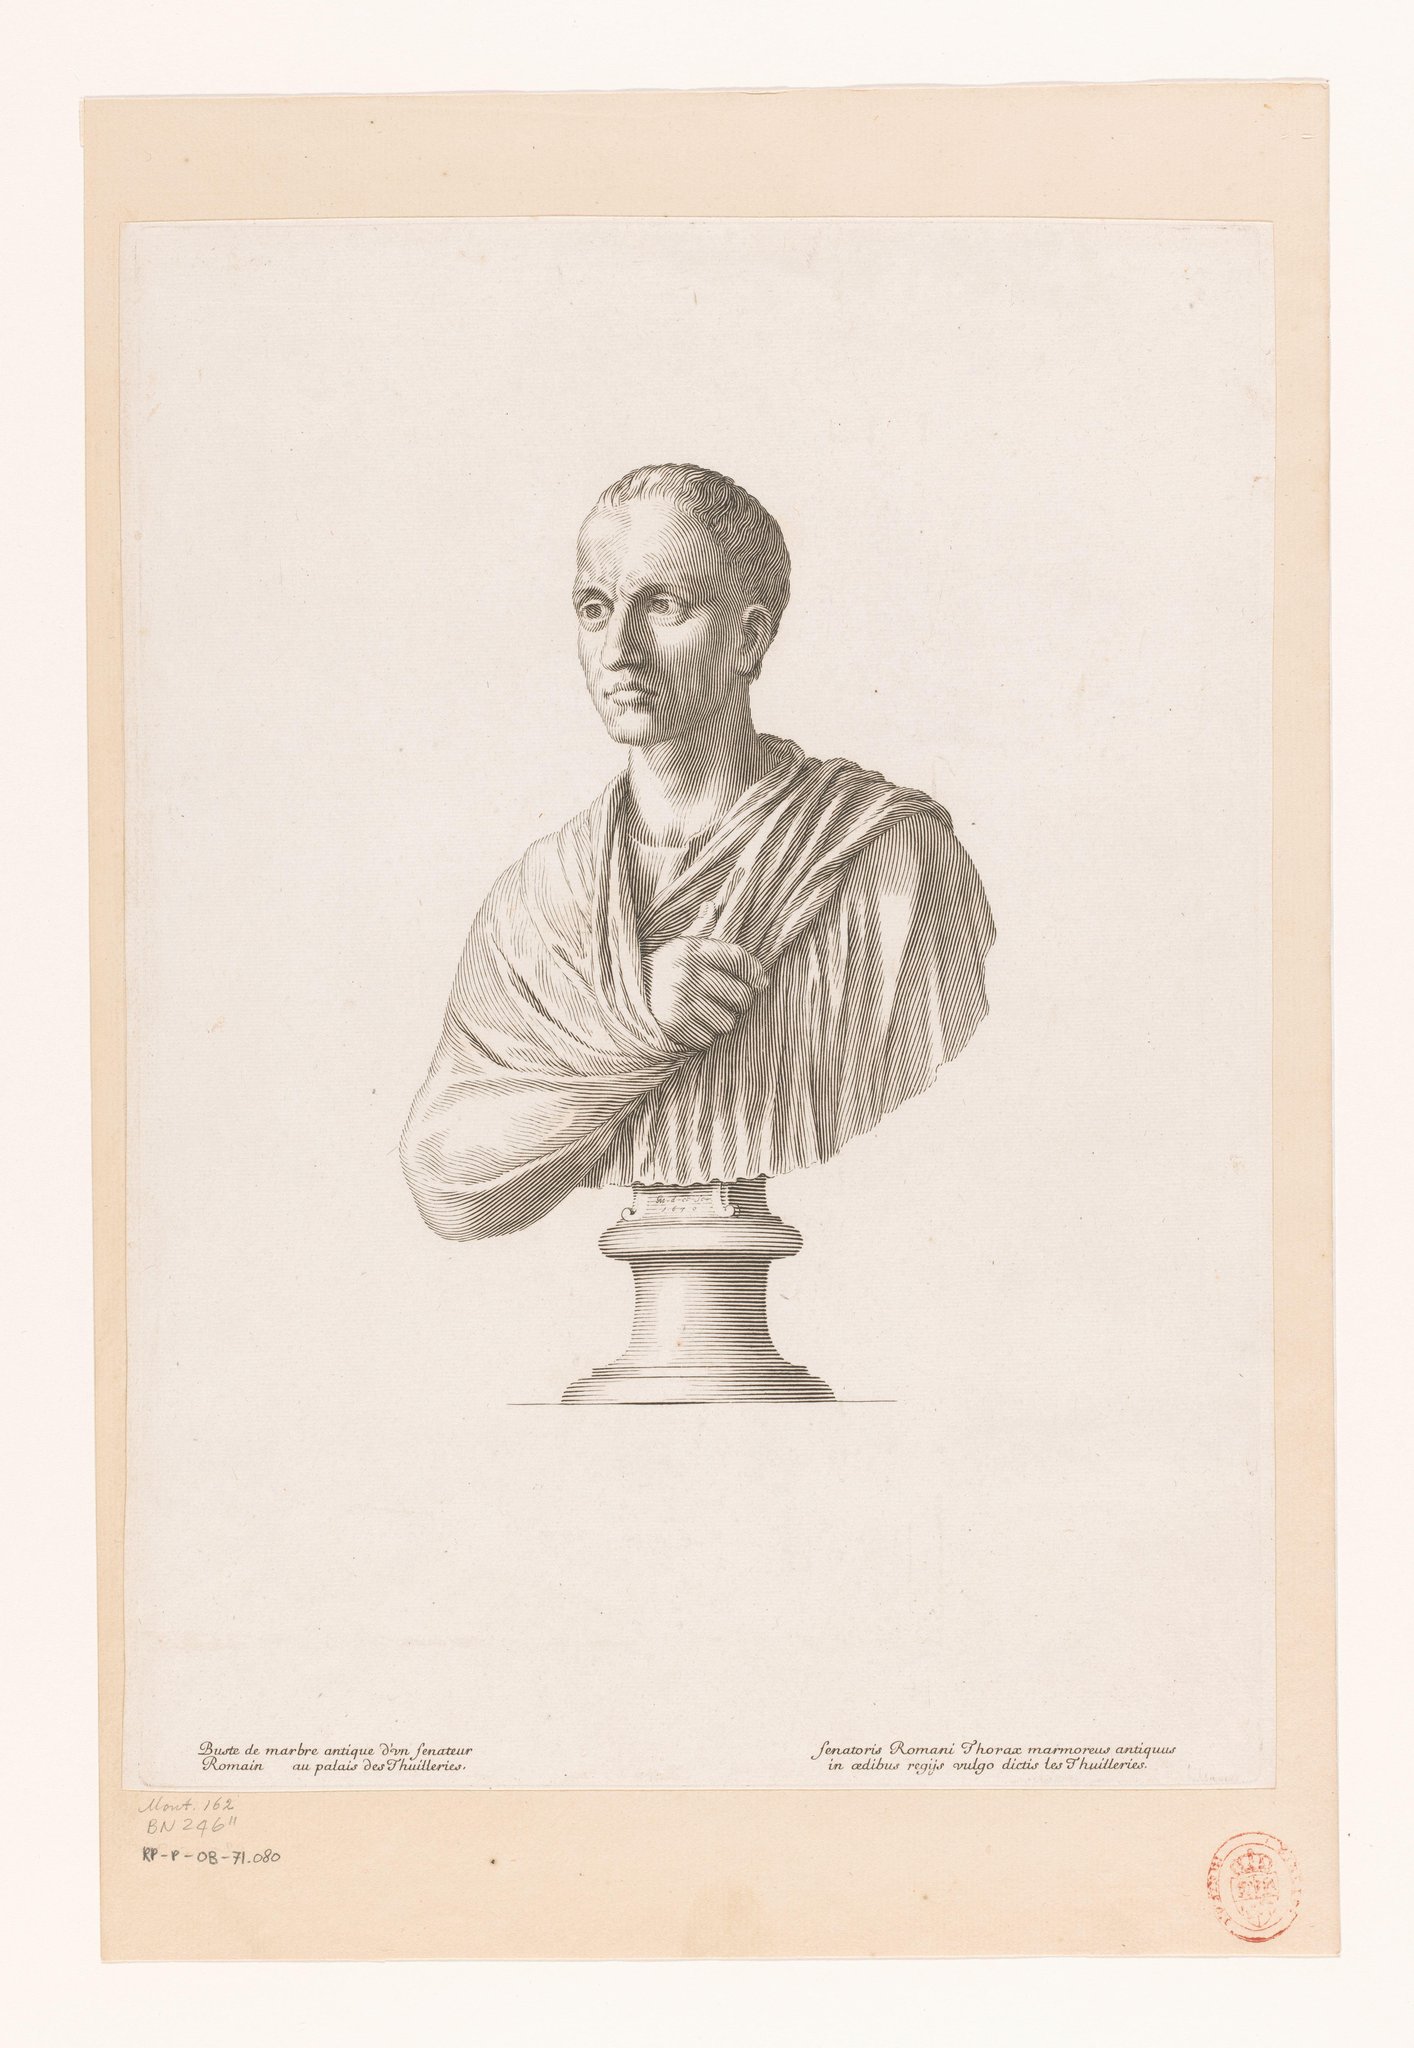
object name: book illustration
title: Beeld van een Romeins senator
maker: claude mellan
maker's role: draughtsman, print maker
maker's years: 1598-1688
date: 1670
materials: paper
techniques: engraving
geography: france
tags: piece of sculpture, reproduction of a piece of sculpture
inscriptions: collector's mark: Lugt 240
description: Prent gebruikt voor: Félibien, André. Tableaux du Cabinet du roy. Statues et bustes antiques des maisons royales. Parijs: Imprimerie Royale, 1677. Het boek bevat 61 prenten van beelden en bustes uit Franse koninklijke collectie. Mellan vervaardigde in totaal achttien platen (zie ook British Museum, inv.nr. 1874,0808.1488). De verblijfplaats van het beeld is onbekend.